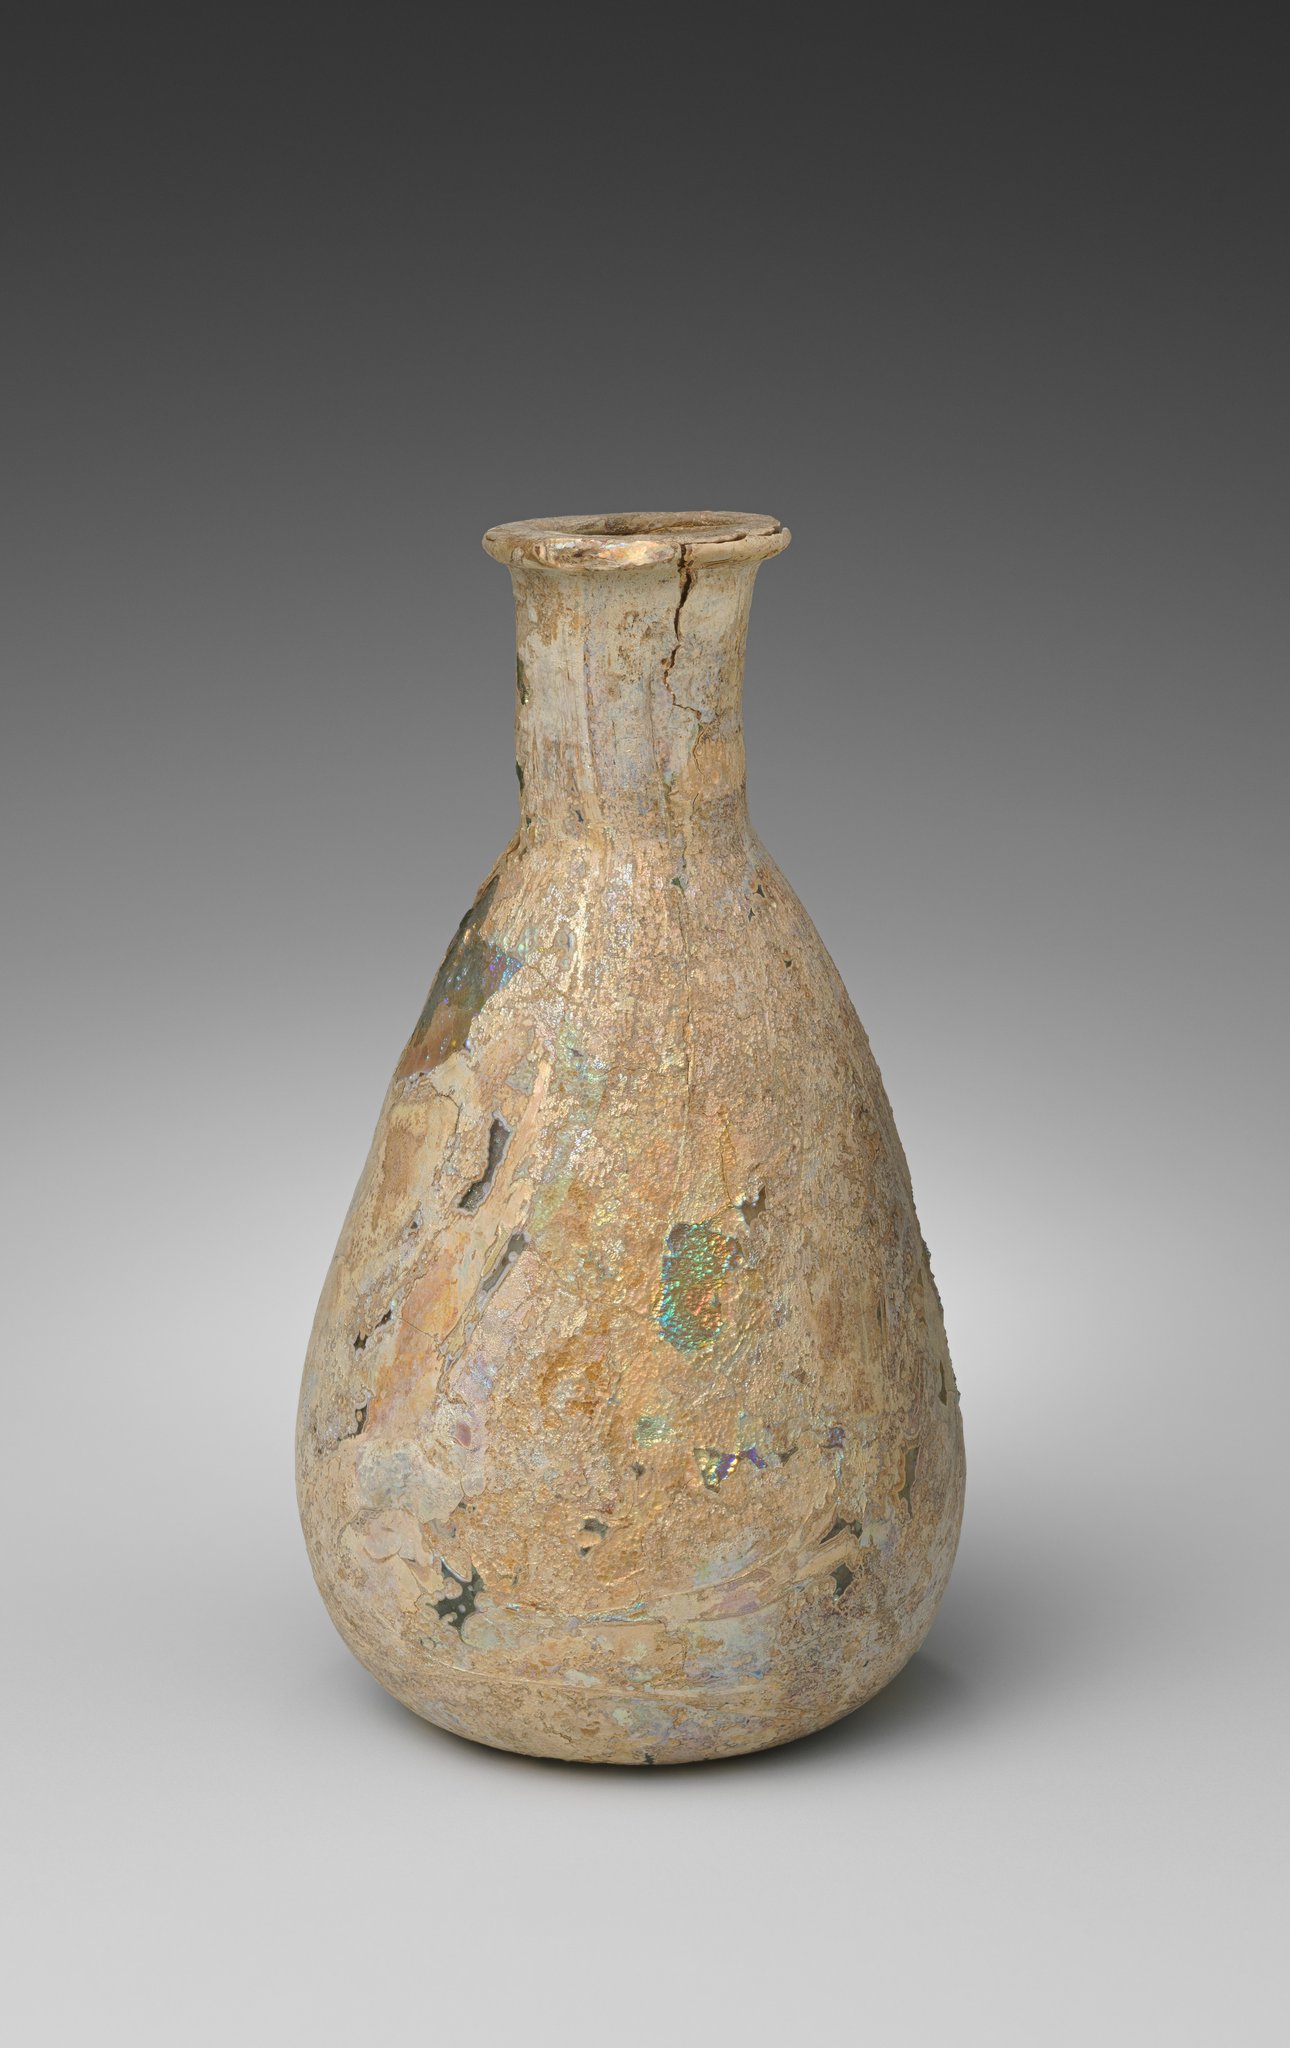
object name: perfume bottle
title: Glass perfume bottle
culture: roman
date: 1-100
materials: glass